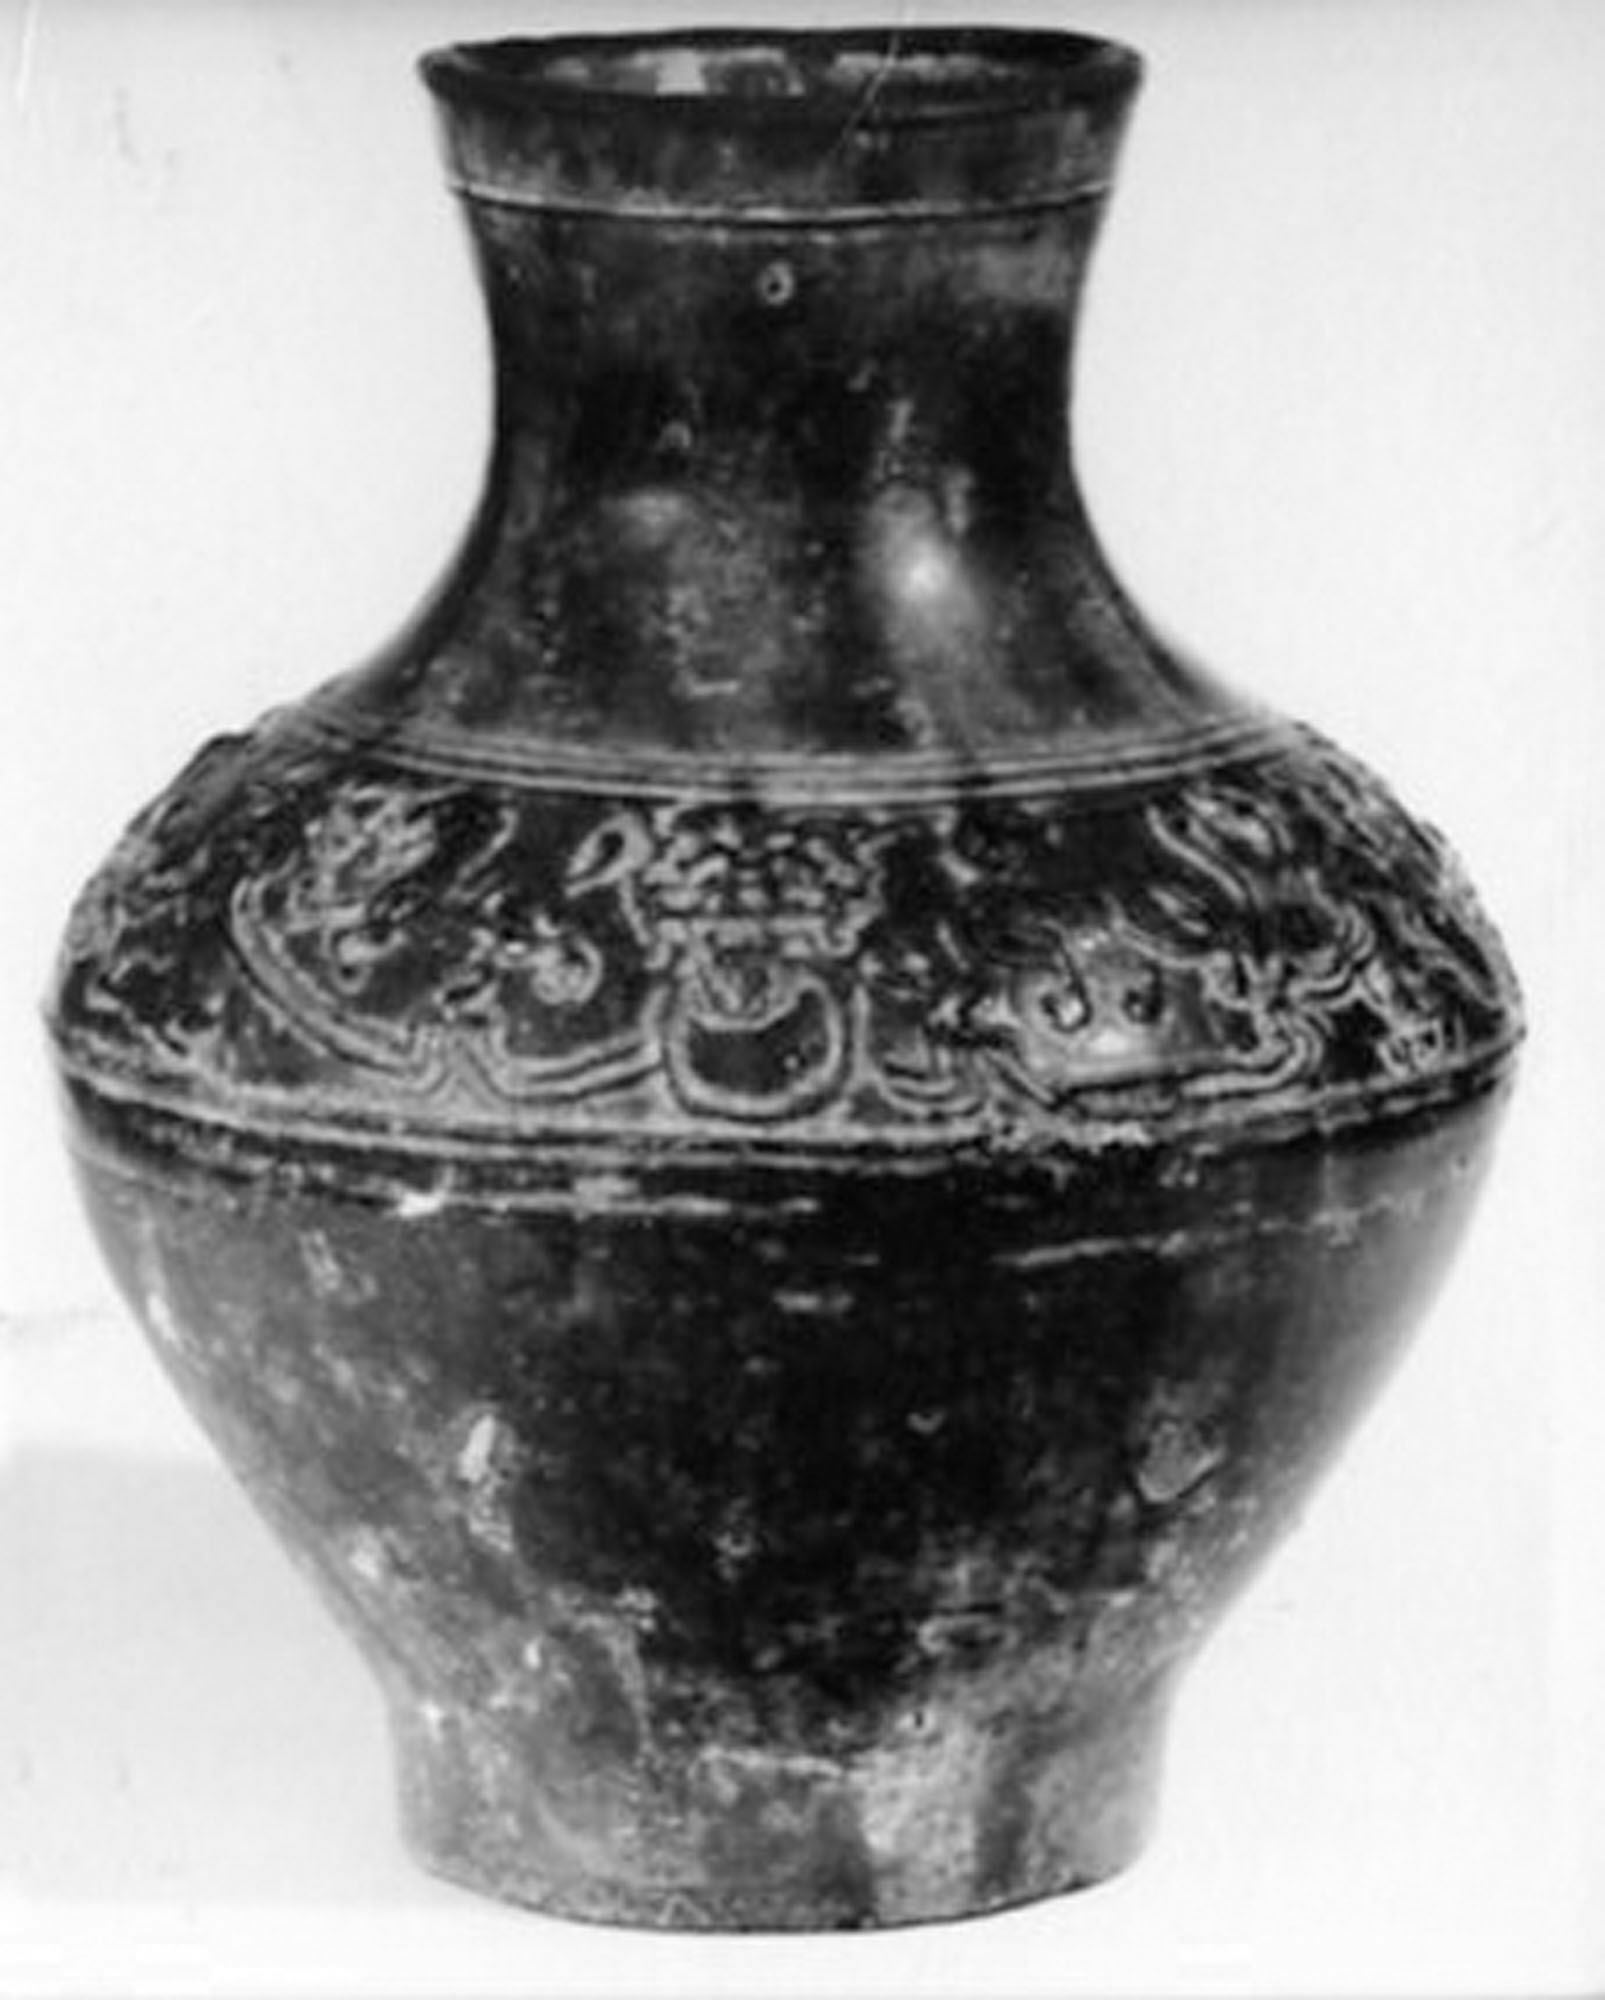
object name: jar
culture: chinese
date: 206 BCE-220 CE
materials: pottery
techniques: glazing